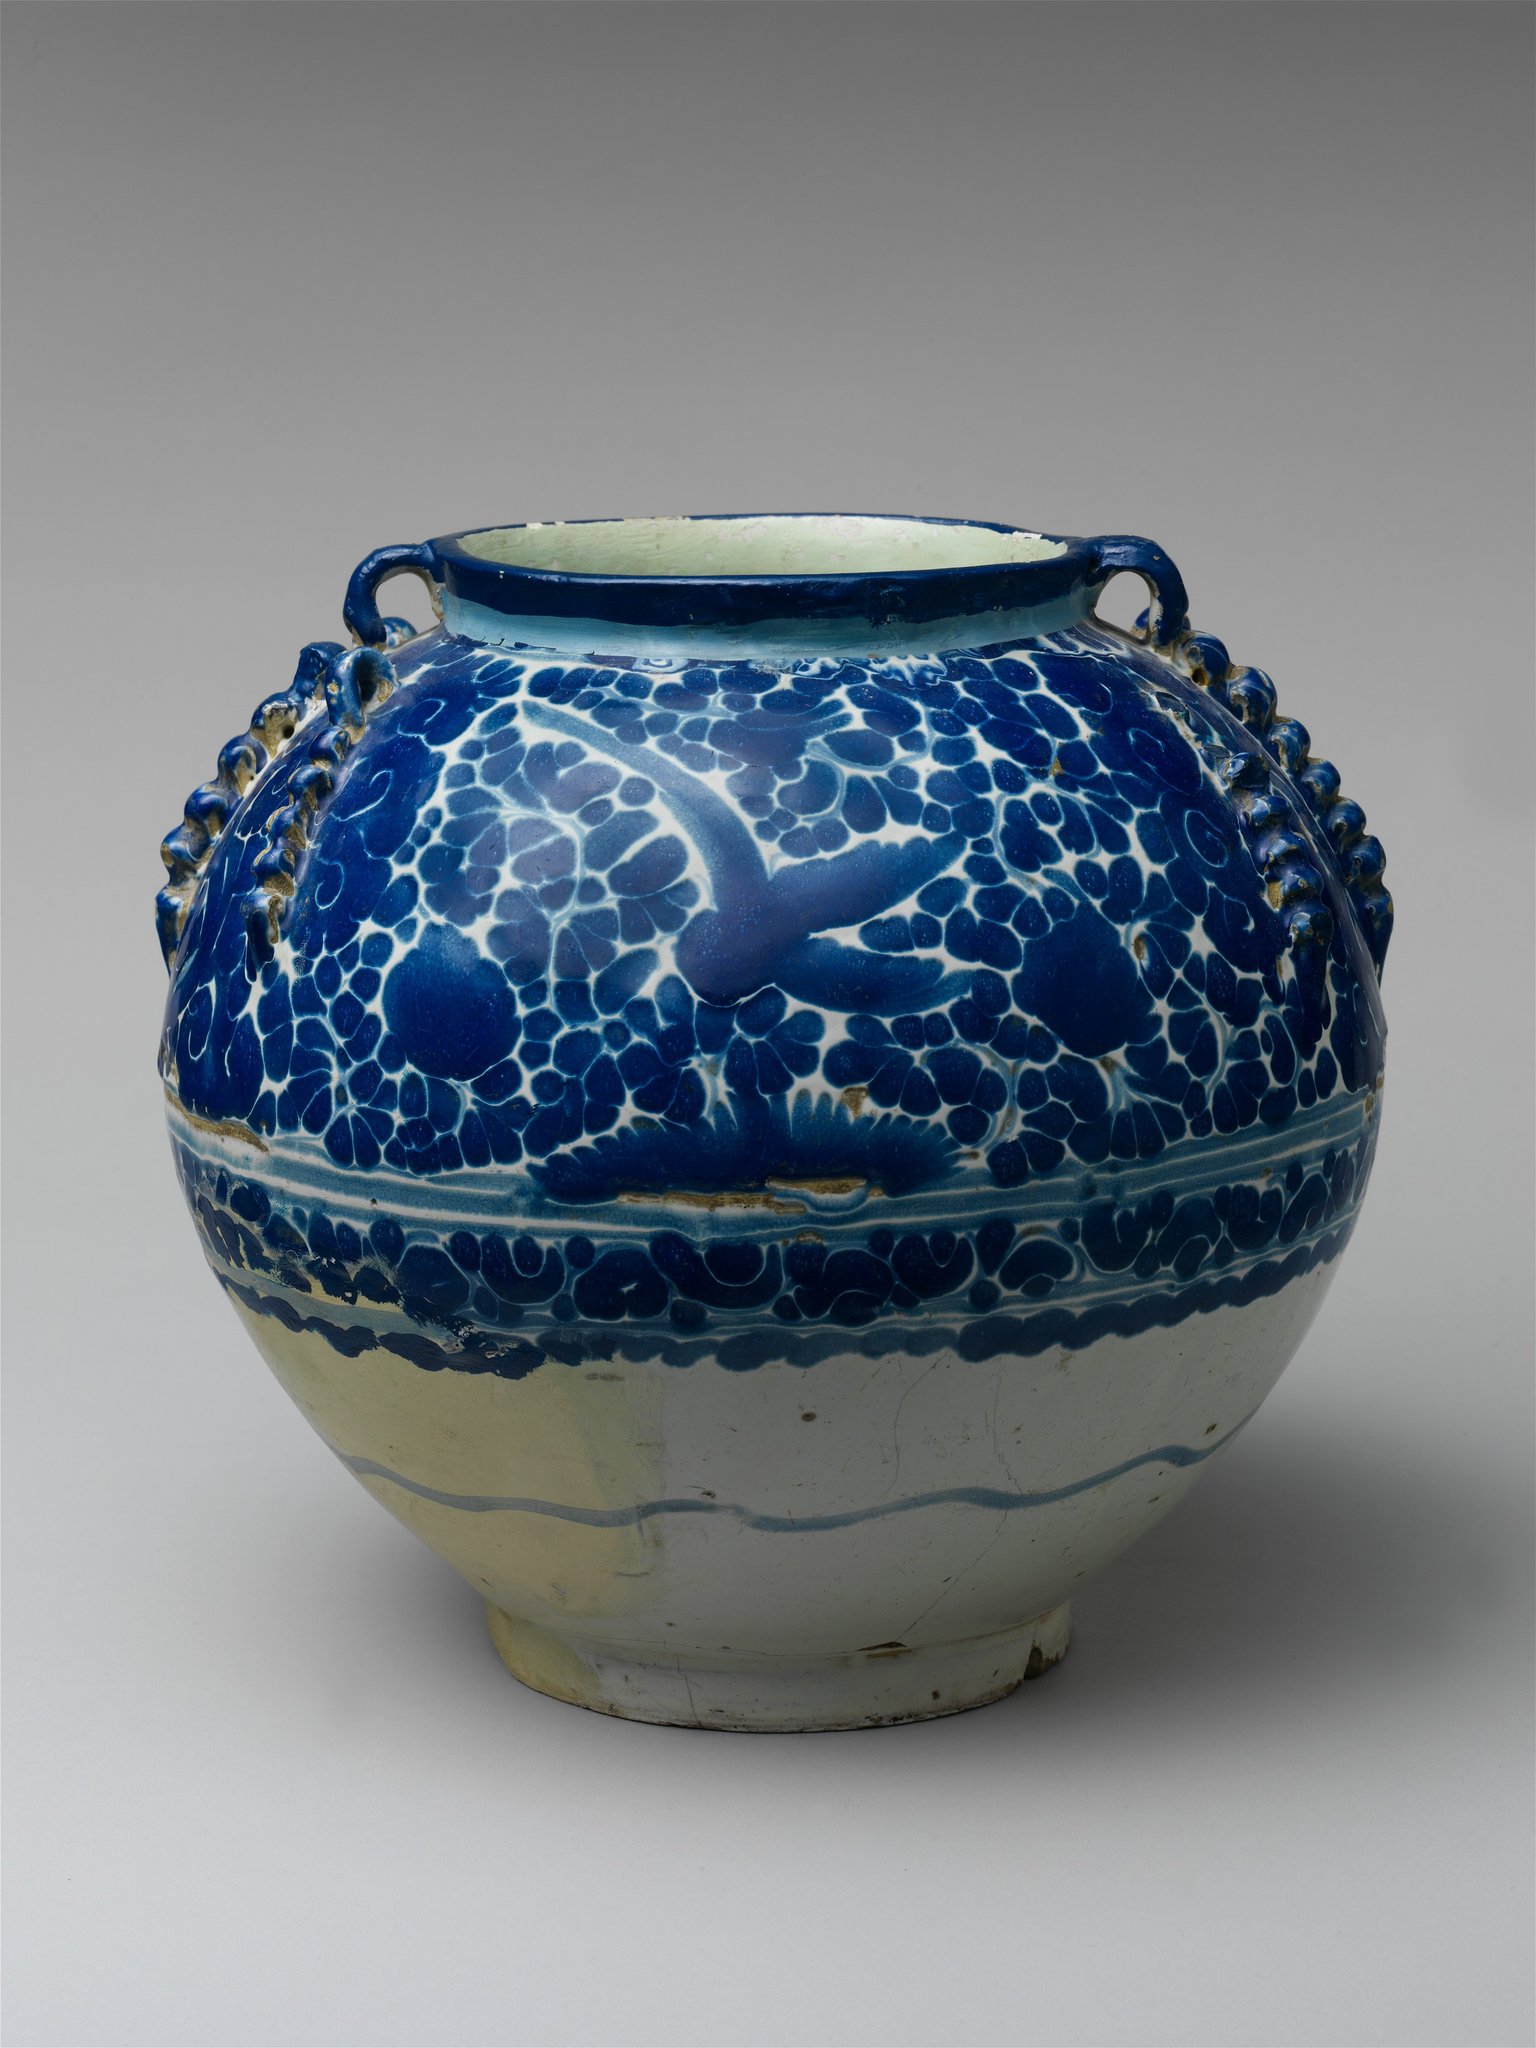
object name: apothecary jar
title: Jar with Serpentine Handles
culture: mexican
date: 1660-1680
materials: earthenware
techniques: glazing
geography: mexico